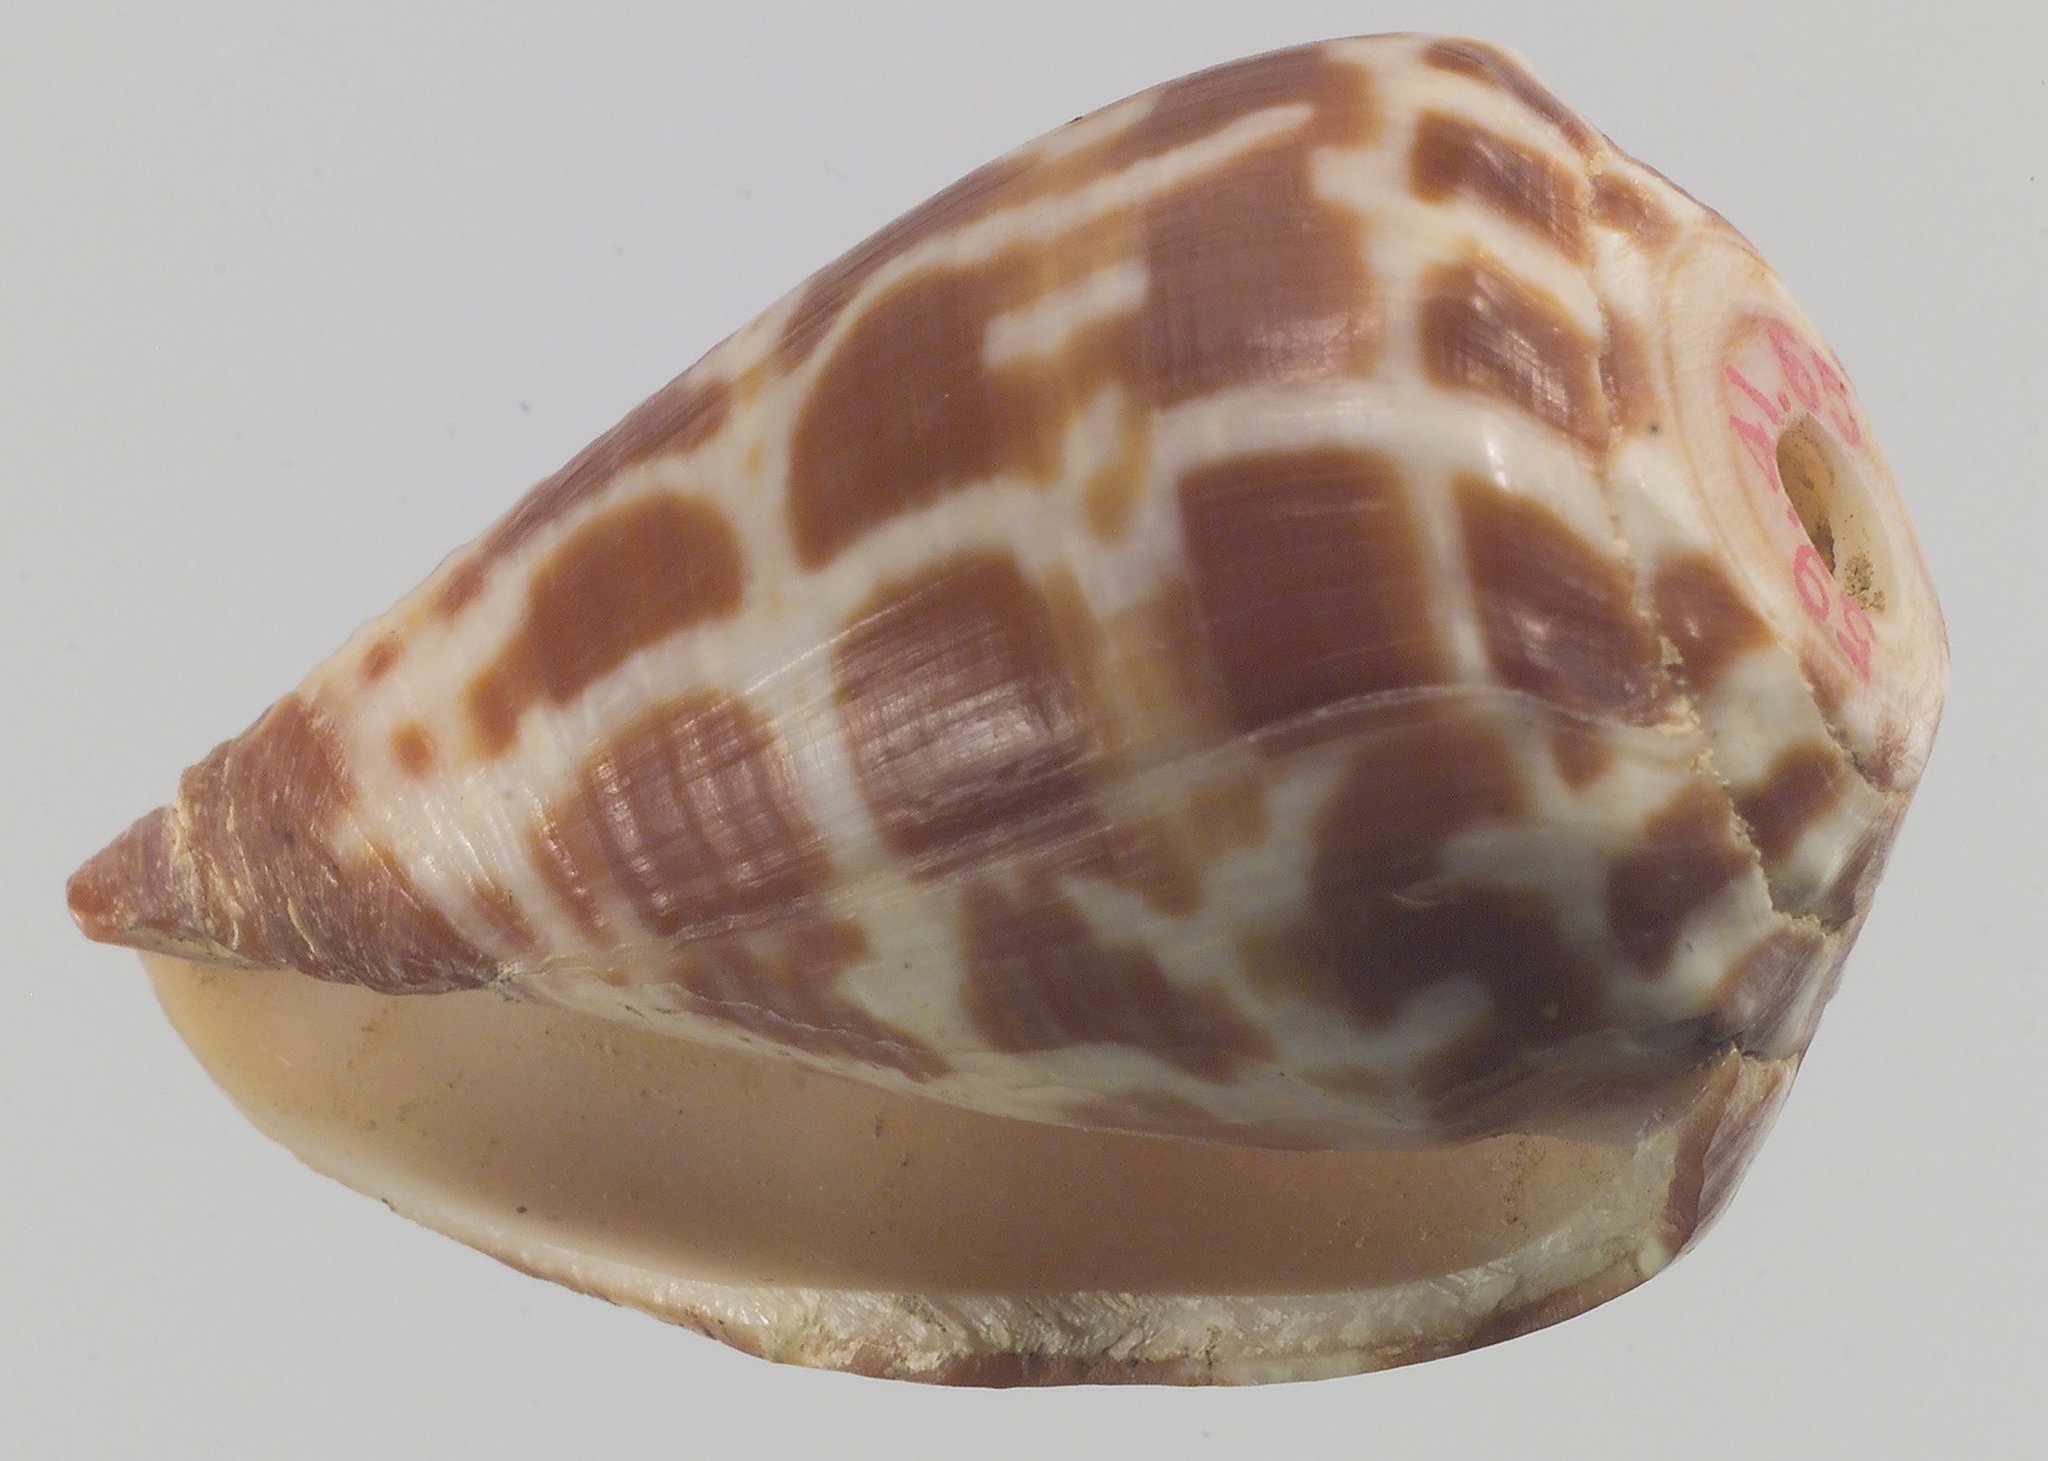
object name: shell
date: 2900-2350 BCE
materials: shell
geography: mesopotamia